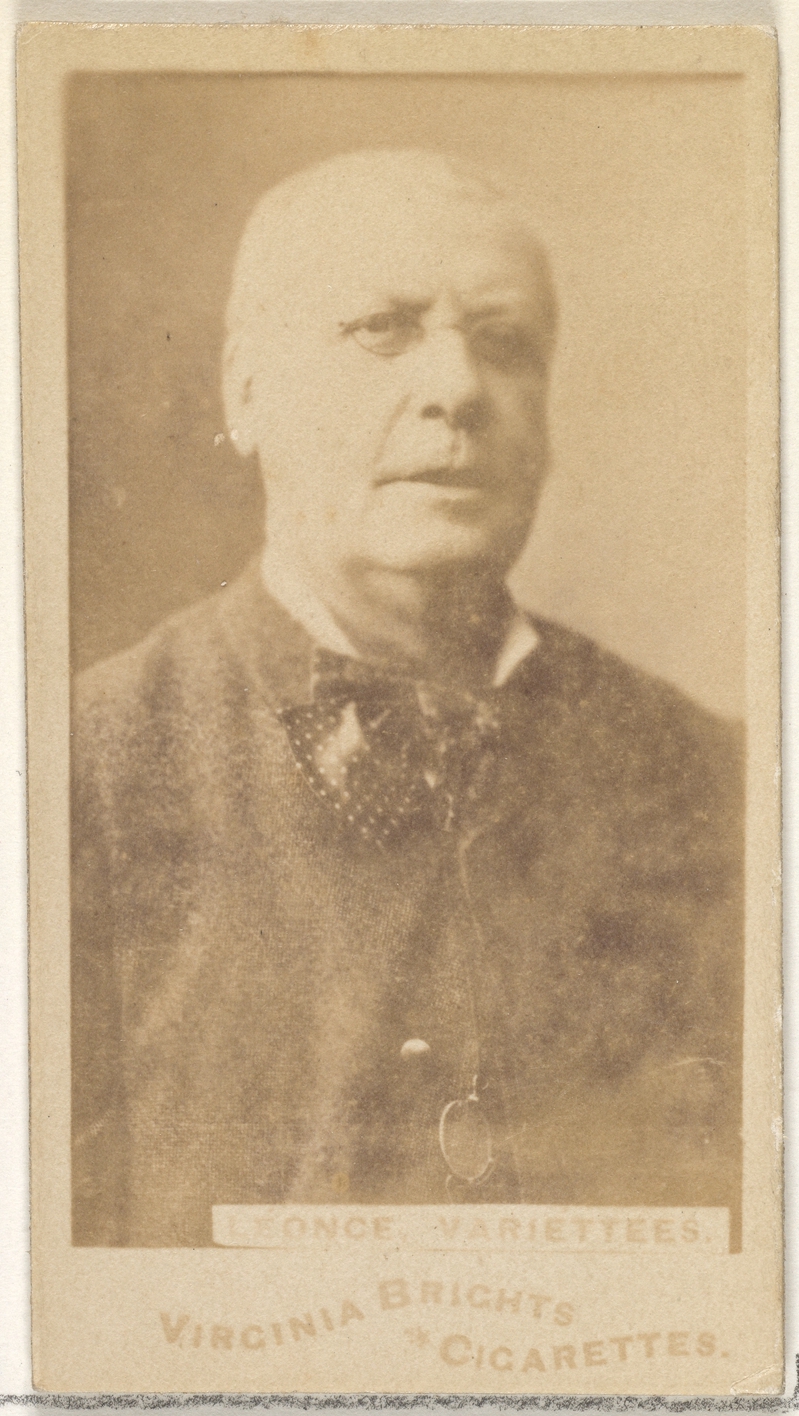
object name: photograph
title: Leonce, Variettees, from the Actors and Actresses series (N45, Type 1) for Virginia Brights Cigarettes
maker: allen & ginter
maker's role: publisher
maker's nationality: american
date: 1888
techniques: albumen silver print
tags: men,portraits,actors